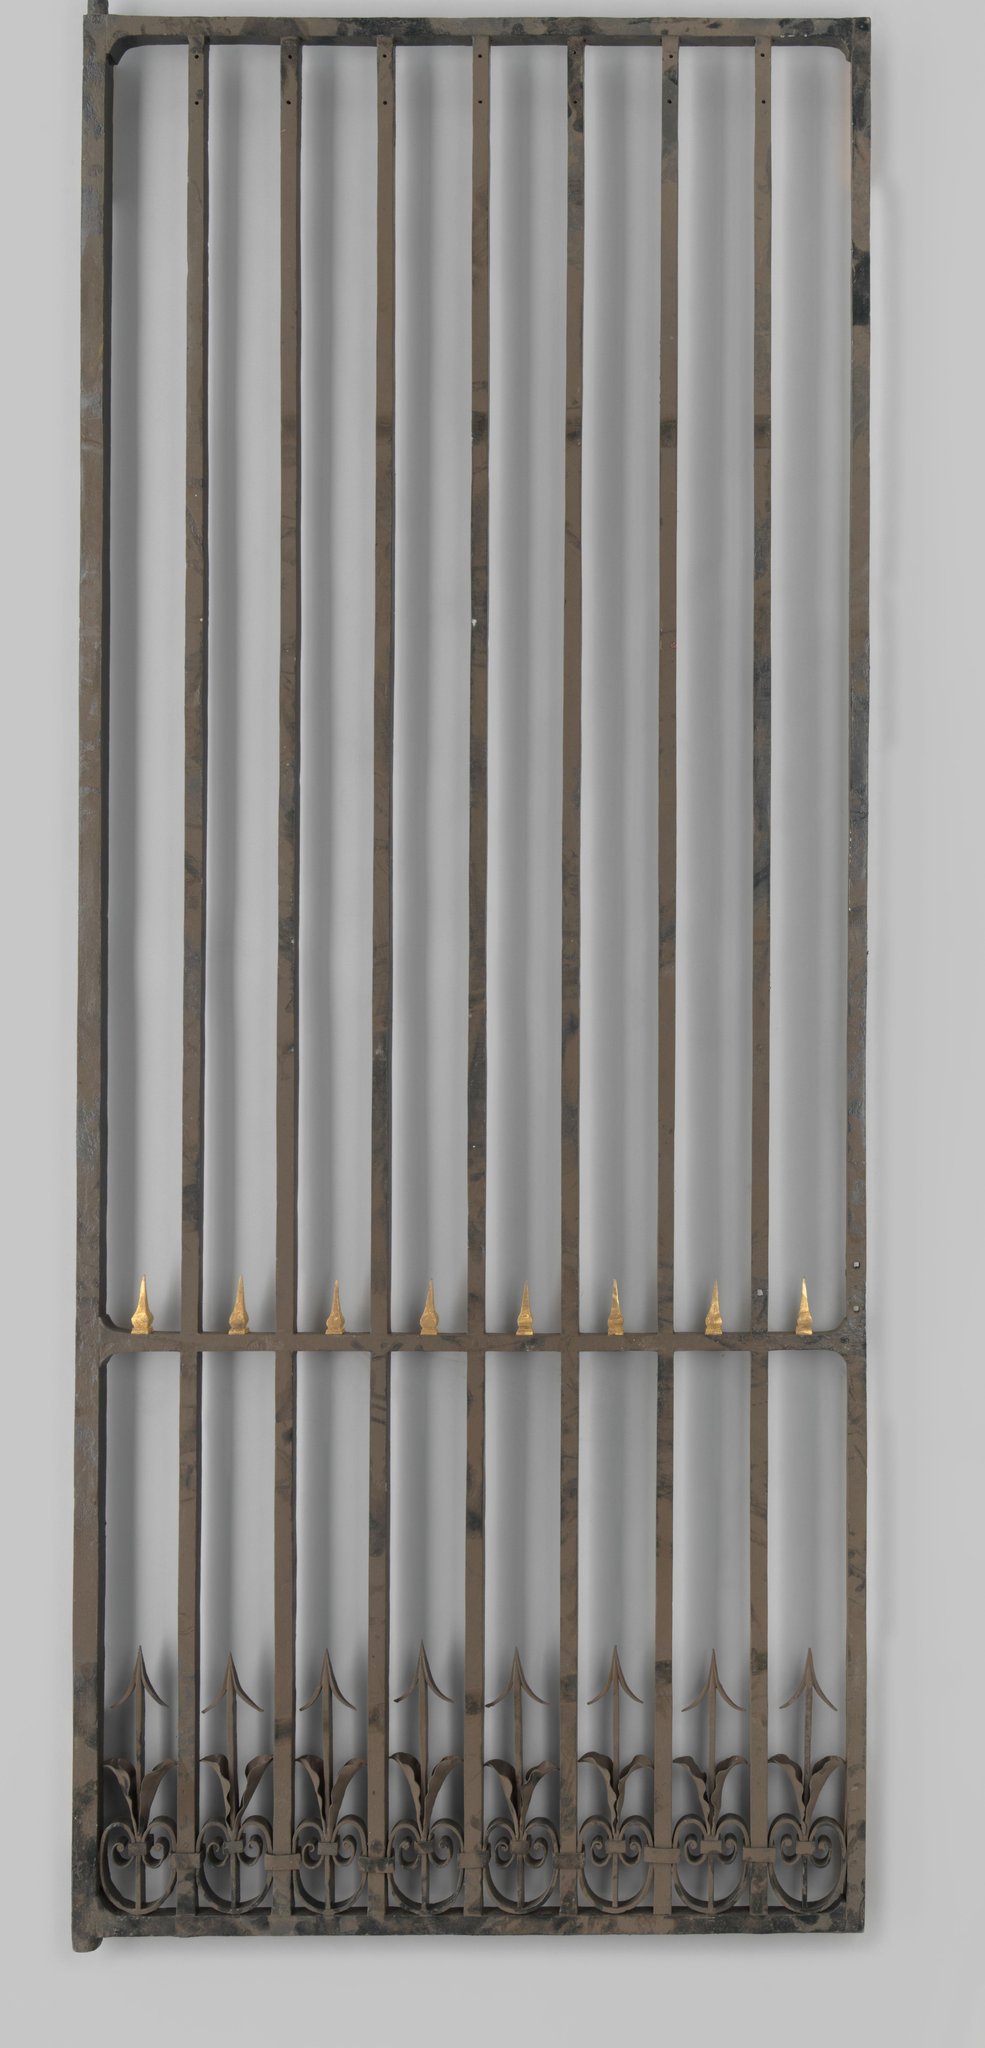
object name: hek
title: Hekdeel van het inrijhek Huize de Voorst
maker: daniël marot (i)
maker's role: draughtsman, print maker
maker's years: 1661-1752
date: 1675-1700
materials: iron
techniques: forging, gilding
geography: warnsveld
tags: huis de voorst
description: Smeedijzeren hekdeel van het inrijhek van Huize de Voorst.